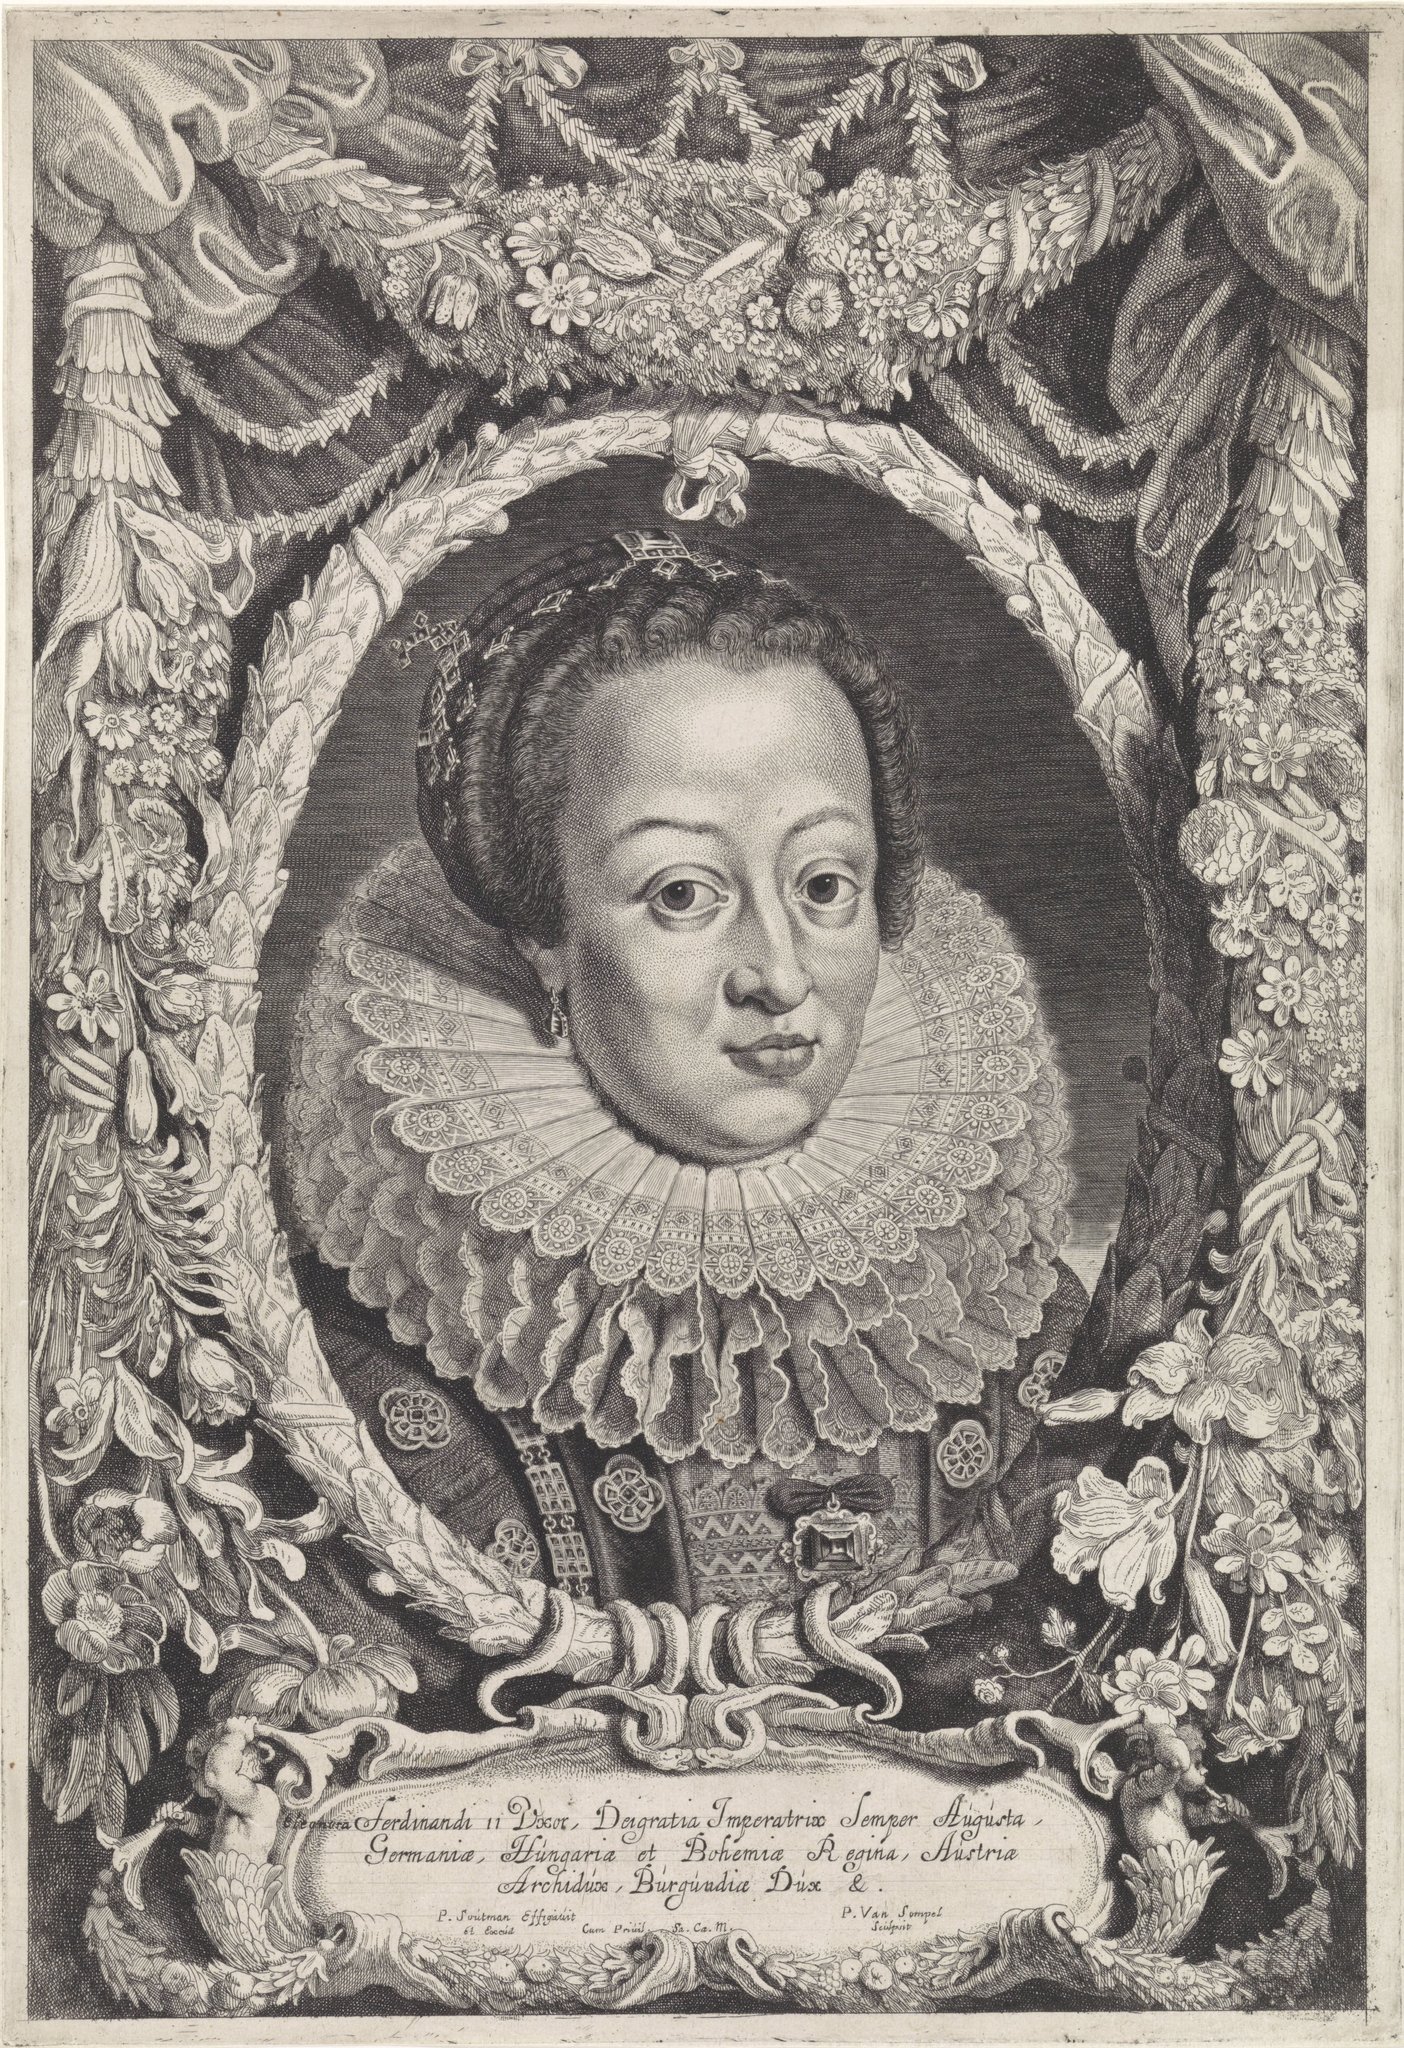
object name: print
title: Ferdinandus II[us] et III[us] Imperatorum Domus Austriacae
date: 1644-1650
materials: paper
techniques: engraving, etching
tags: keizerin, eleonora gonzaga (1598-1655)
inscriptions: collector's mark: Lugt 2228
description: Portret van Eleonora Conzaga, echtgenote van de Duitse keizer Ferdinand II. Het portret wordt omlijst door bloemrijke guirlandes. Onder het portret een cartouche met in het Latijn haar titels. In handschrift is haar naam toegevoegd.